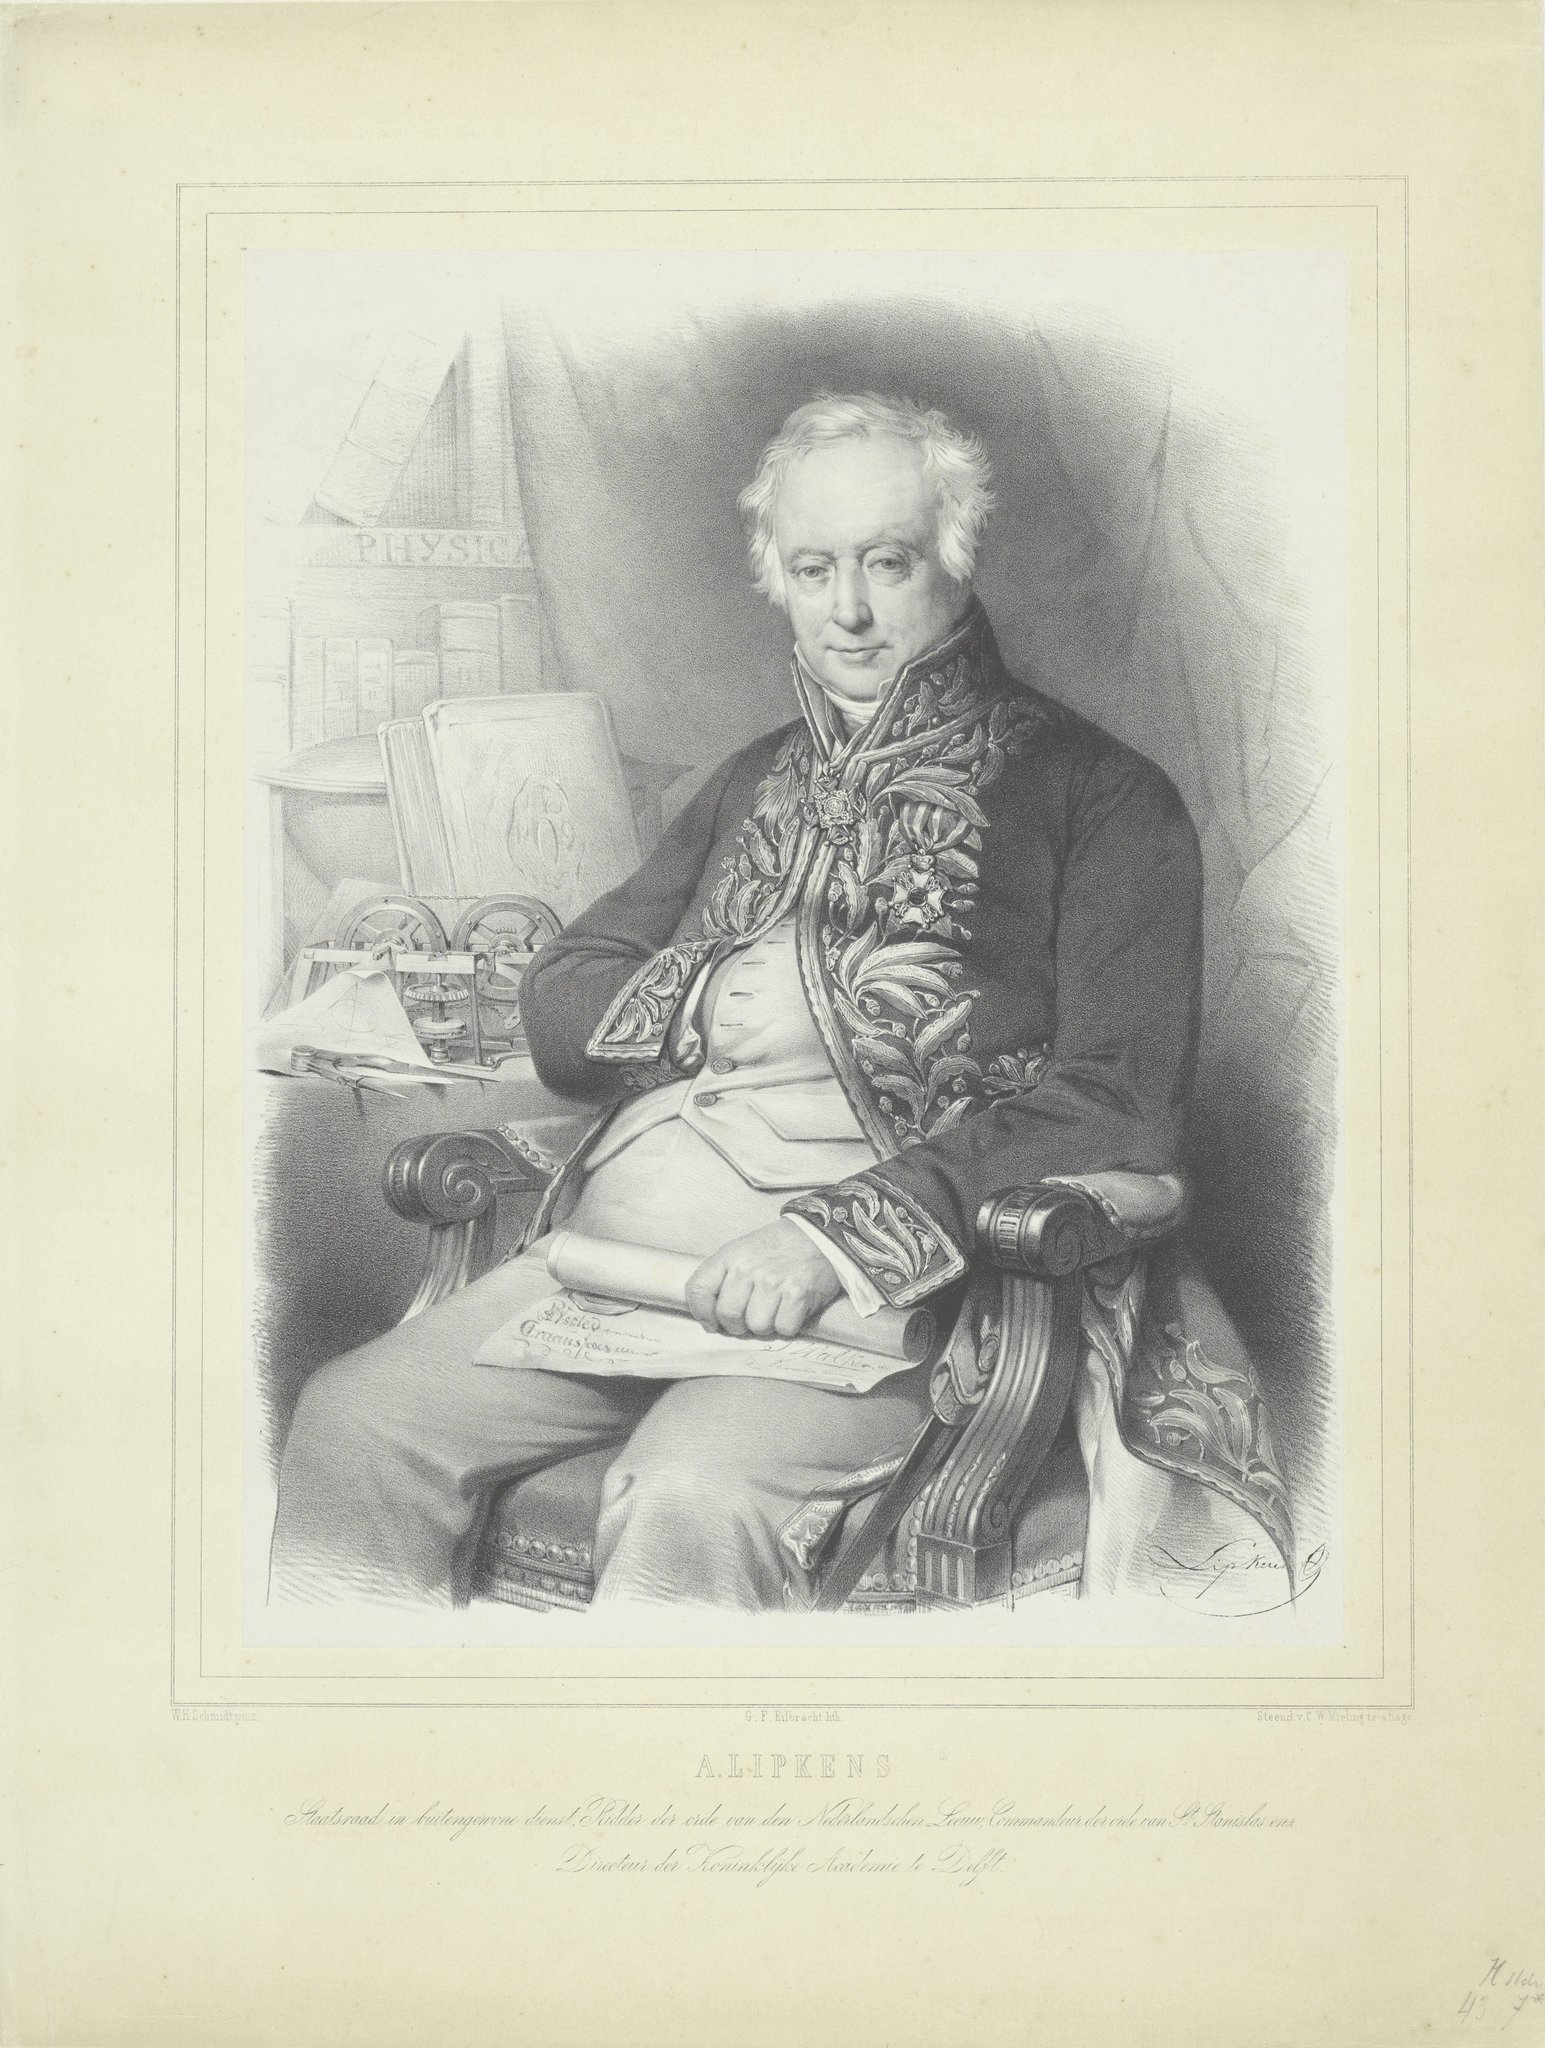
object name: print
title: Portret van Antoine Lipkens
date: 1845-1854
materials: paper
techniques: lithograph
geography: the hague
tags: maastricht, engineer, antoine lipkens, knighthood order, book (+ portrait of scholar, scientist), compasses, historical persons (+ half-length portrait)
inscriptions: collector's mark: Lugt 2228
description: De geportretteerde zit voor een gordijn in luxe stoel en draagt een galakostuum met ridderorden. In zijn linkerhand houdt hij een opgerold beschreven stuk papier en zijn rechterhand heeft hij in zijn gilet gestoken. Links naast hem een tafel met daarop boeken, tekeningen en instrumenten en een boekenkast met boeken over natuurkunde. Onder het portret zijn naam en een tweeregelig onderschrift.